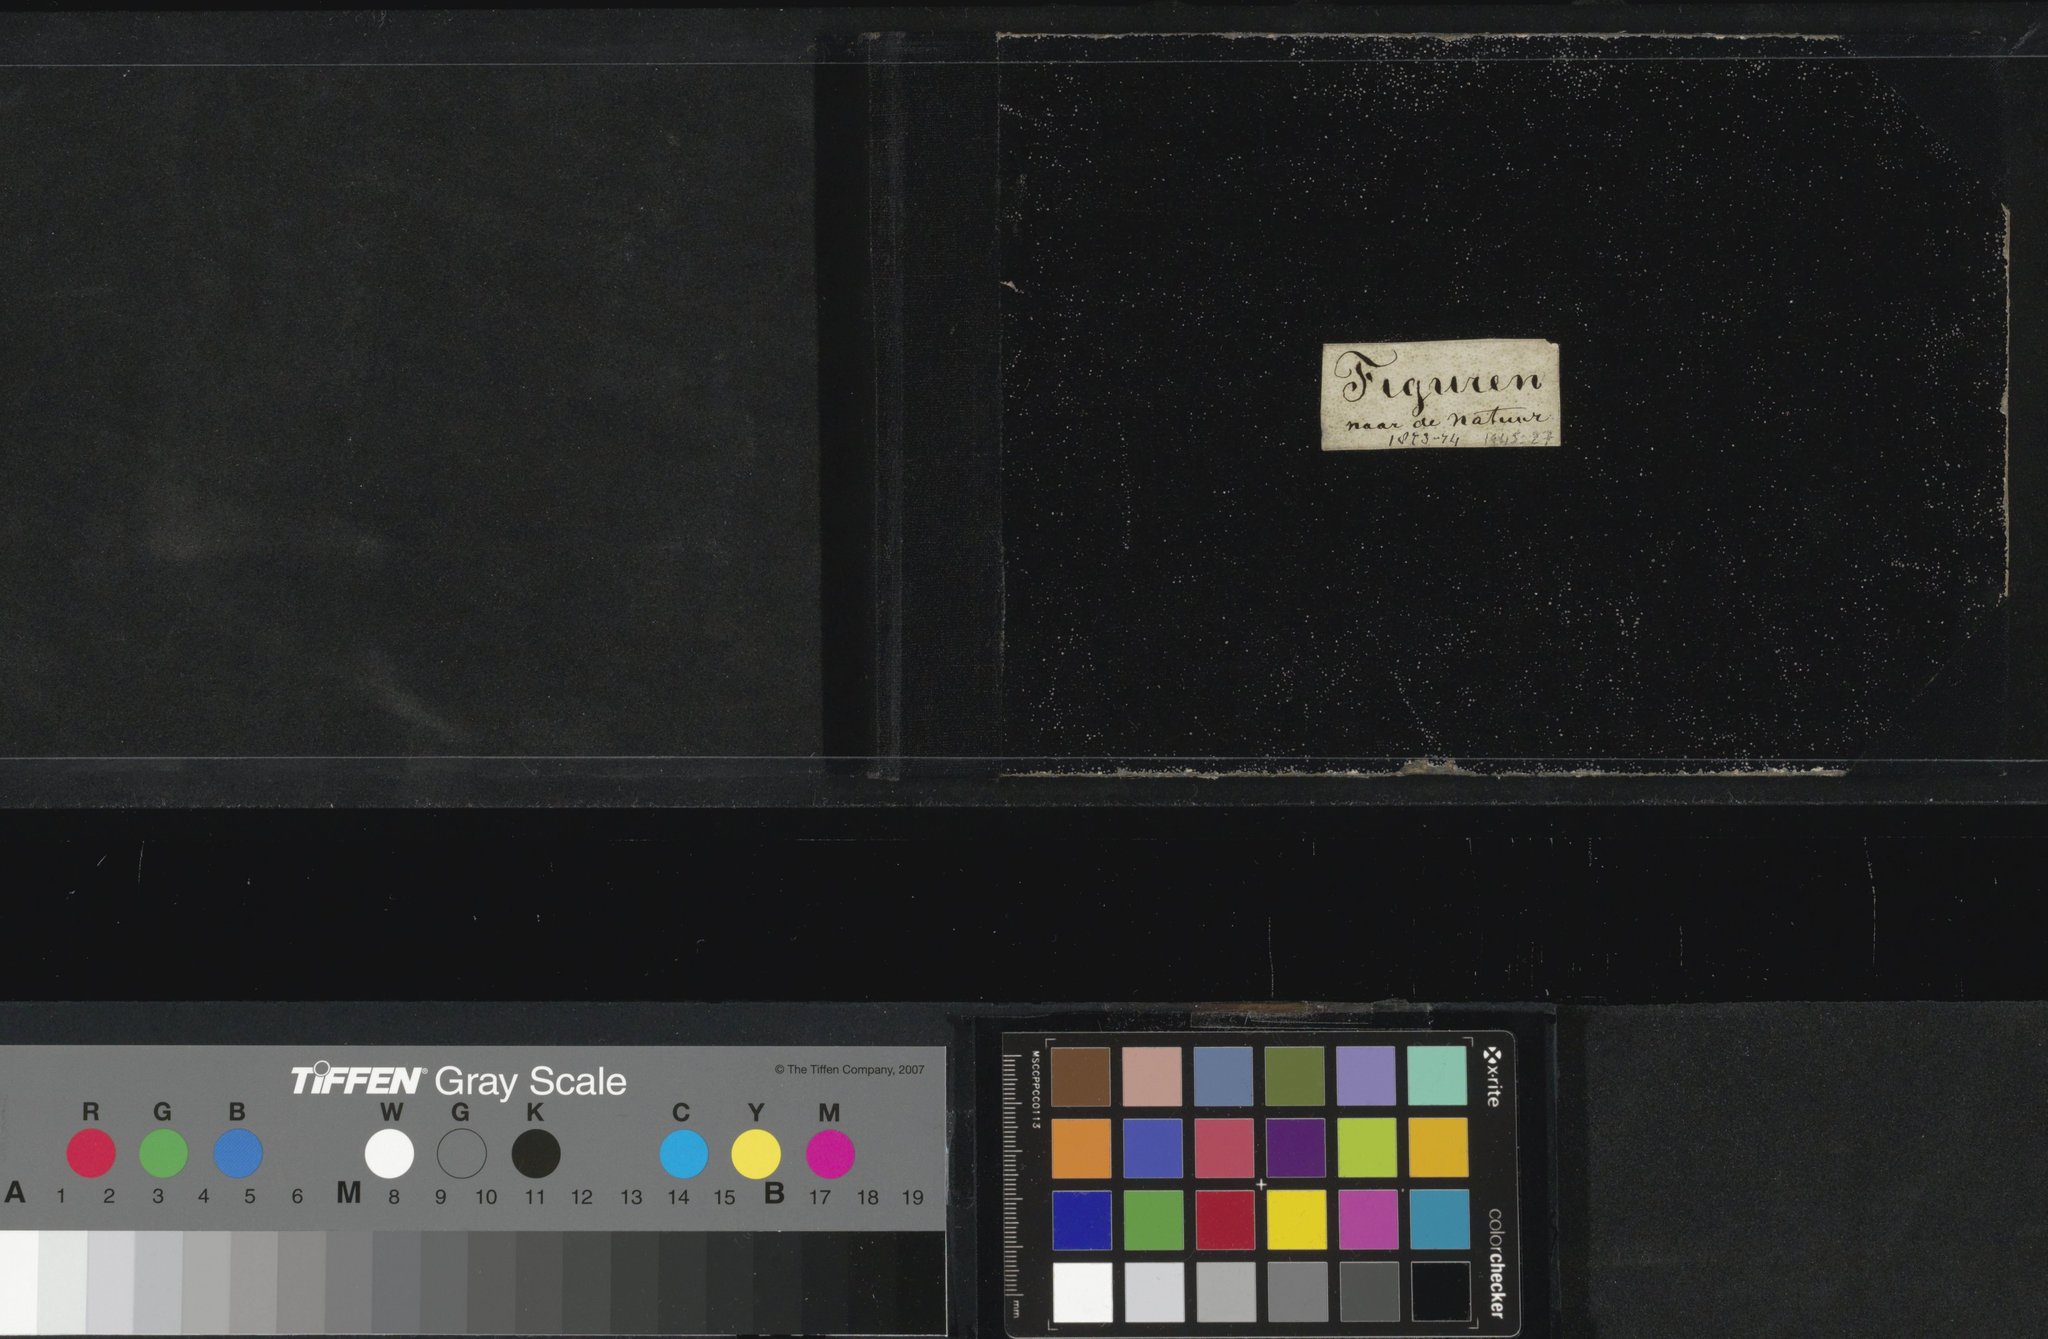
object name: sketchbook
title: Schetsboek met 46 bladen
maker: cornelis springer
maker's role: draughtsman, painter, print maker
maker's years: 1817-1891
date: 1873-1874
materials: linen, paper, pencil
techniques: stumping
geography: netherlands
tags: adult woman, adult man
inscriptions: annotation: ‘Figuren/ naar de natuur/ 1873-74’, collector's mark: Lugt 2228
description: Schetsboek bestaande uit 46 bladen met figuurstudies.